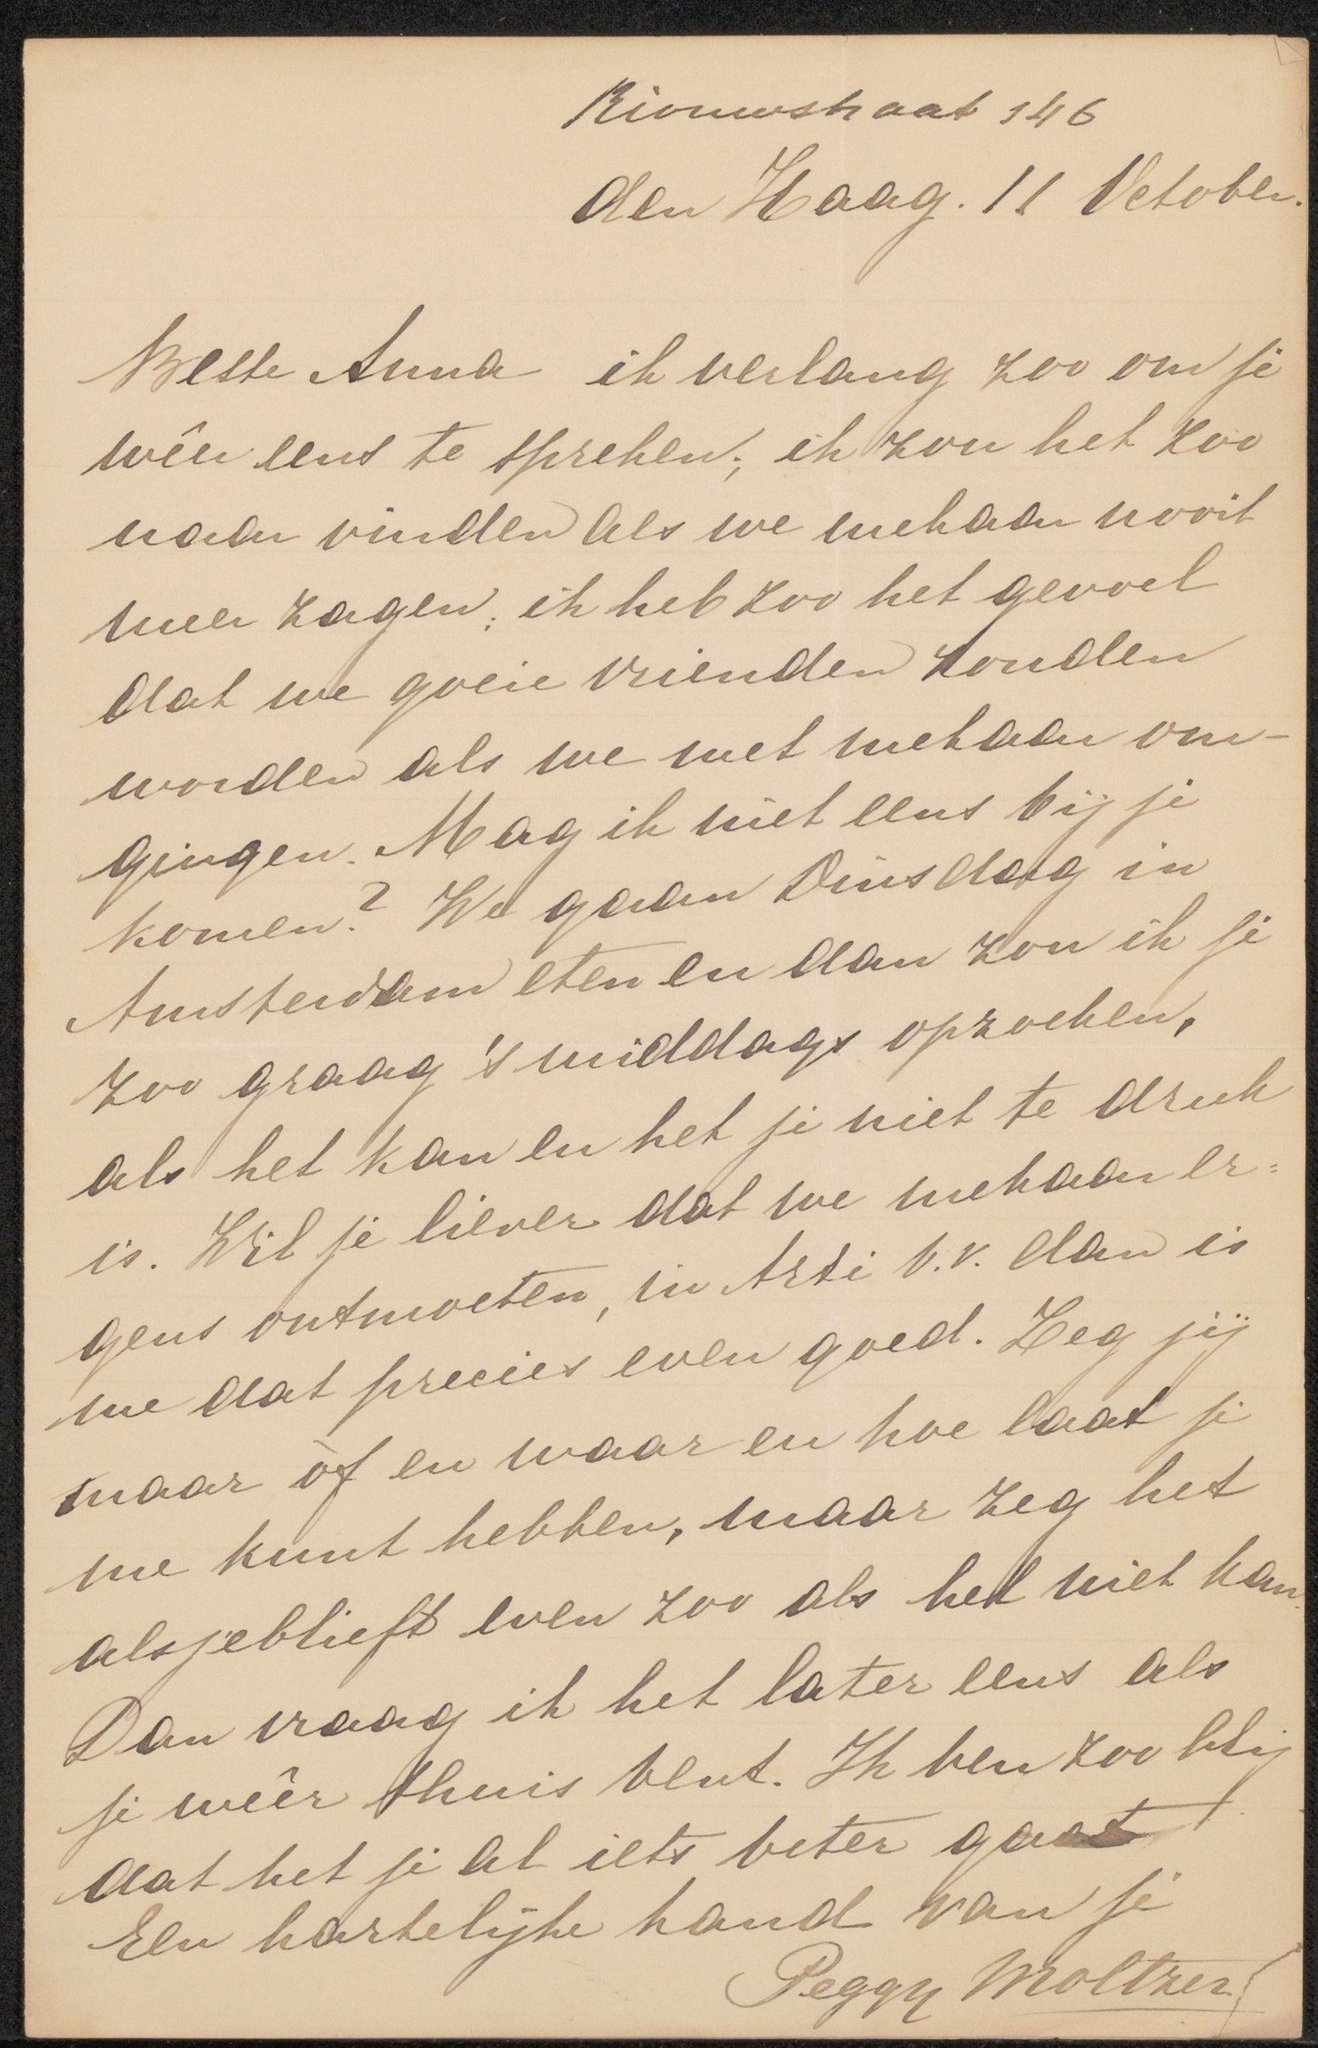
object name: letter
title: Brief aan Anna Dorothea Dirks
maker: peggy nicoline kappeyne van de coppello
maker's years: 1851-1924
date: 1899-1924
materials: ink, paper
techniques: pen, writing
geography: the hague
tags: artist, anna dorothea dirks, amsterdam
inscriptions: collector's mark: ‘RPK’